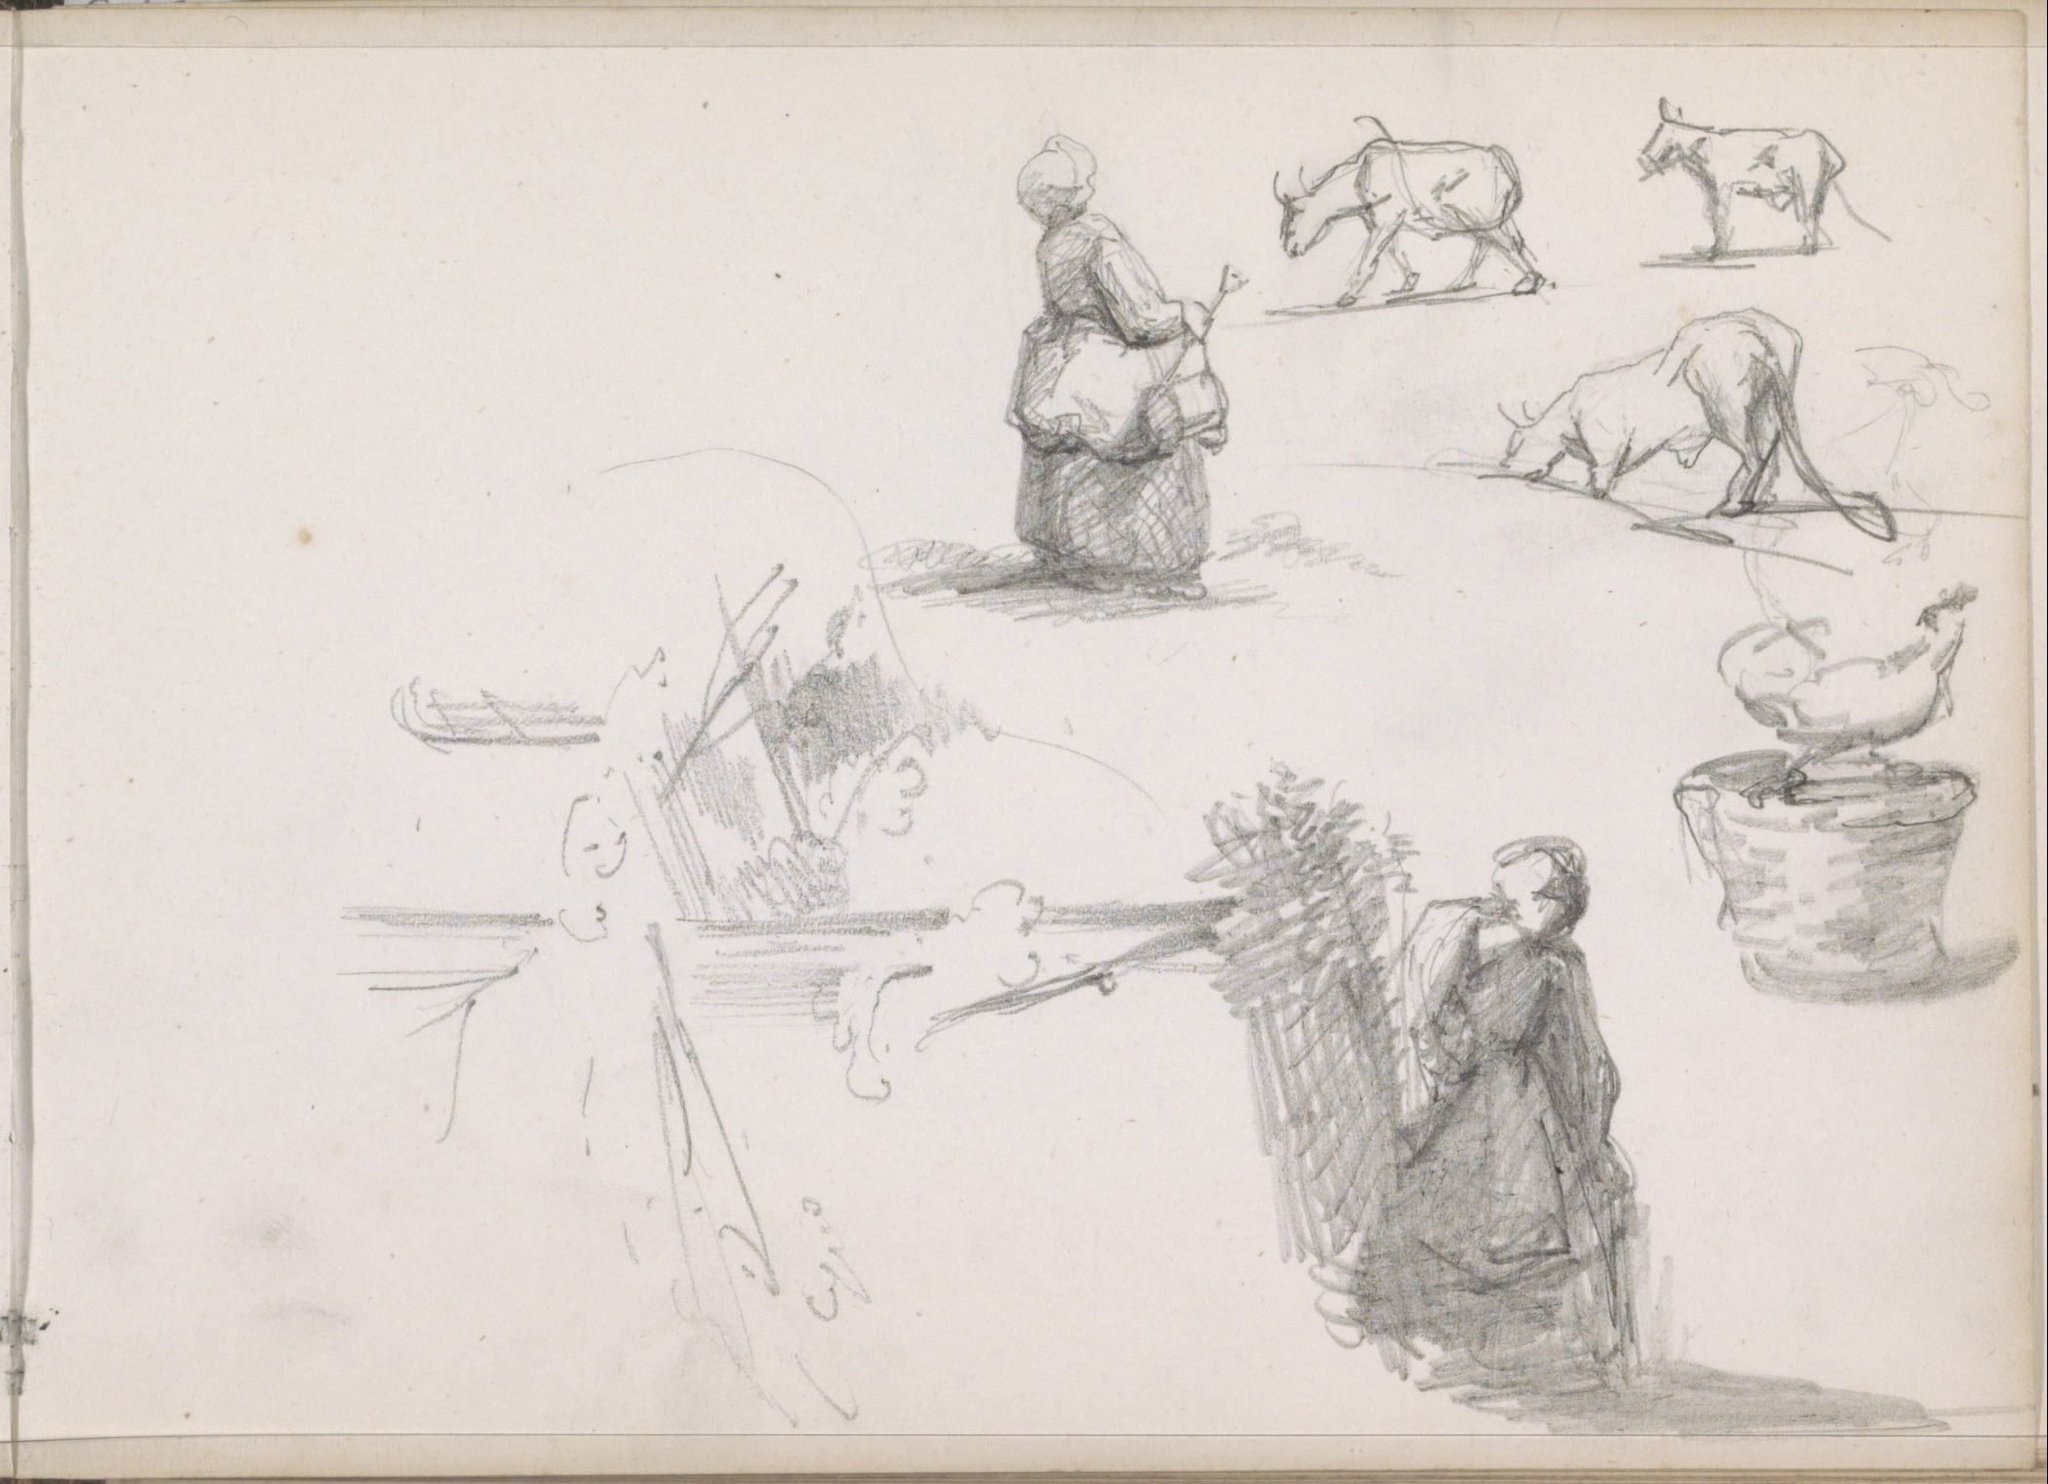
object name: sketchbook leaf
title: Studieblad, onder andere met koeien, een kip en een boerin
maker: maria vos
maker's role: draughtsman, painter, print maker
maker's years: 1824-1906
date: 1834-1906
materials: paper, pencil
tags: cow, farmers - aa - female farmer, farmer's wife, fowl (cock, hen, chicken, etc.)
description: Blad 8 recto uit een schetsboek met 30 bladen.